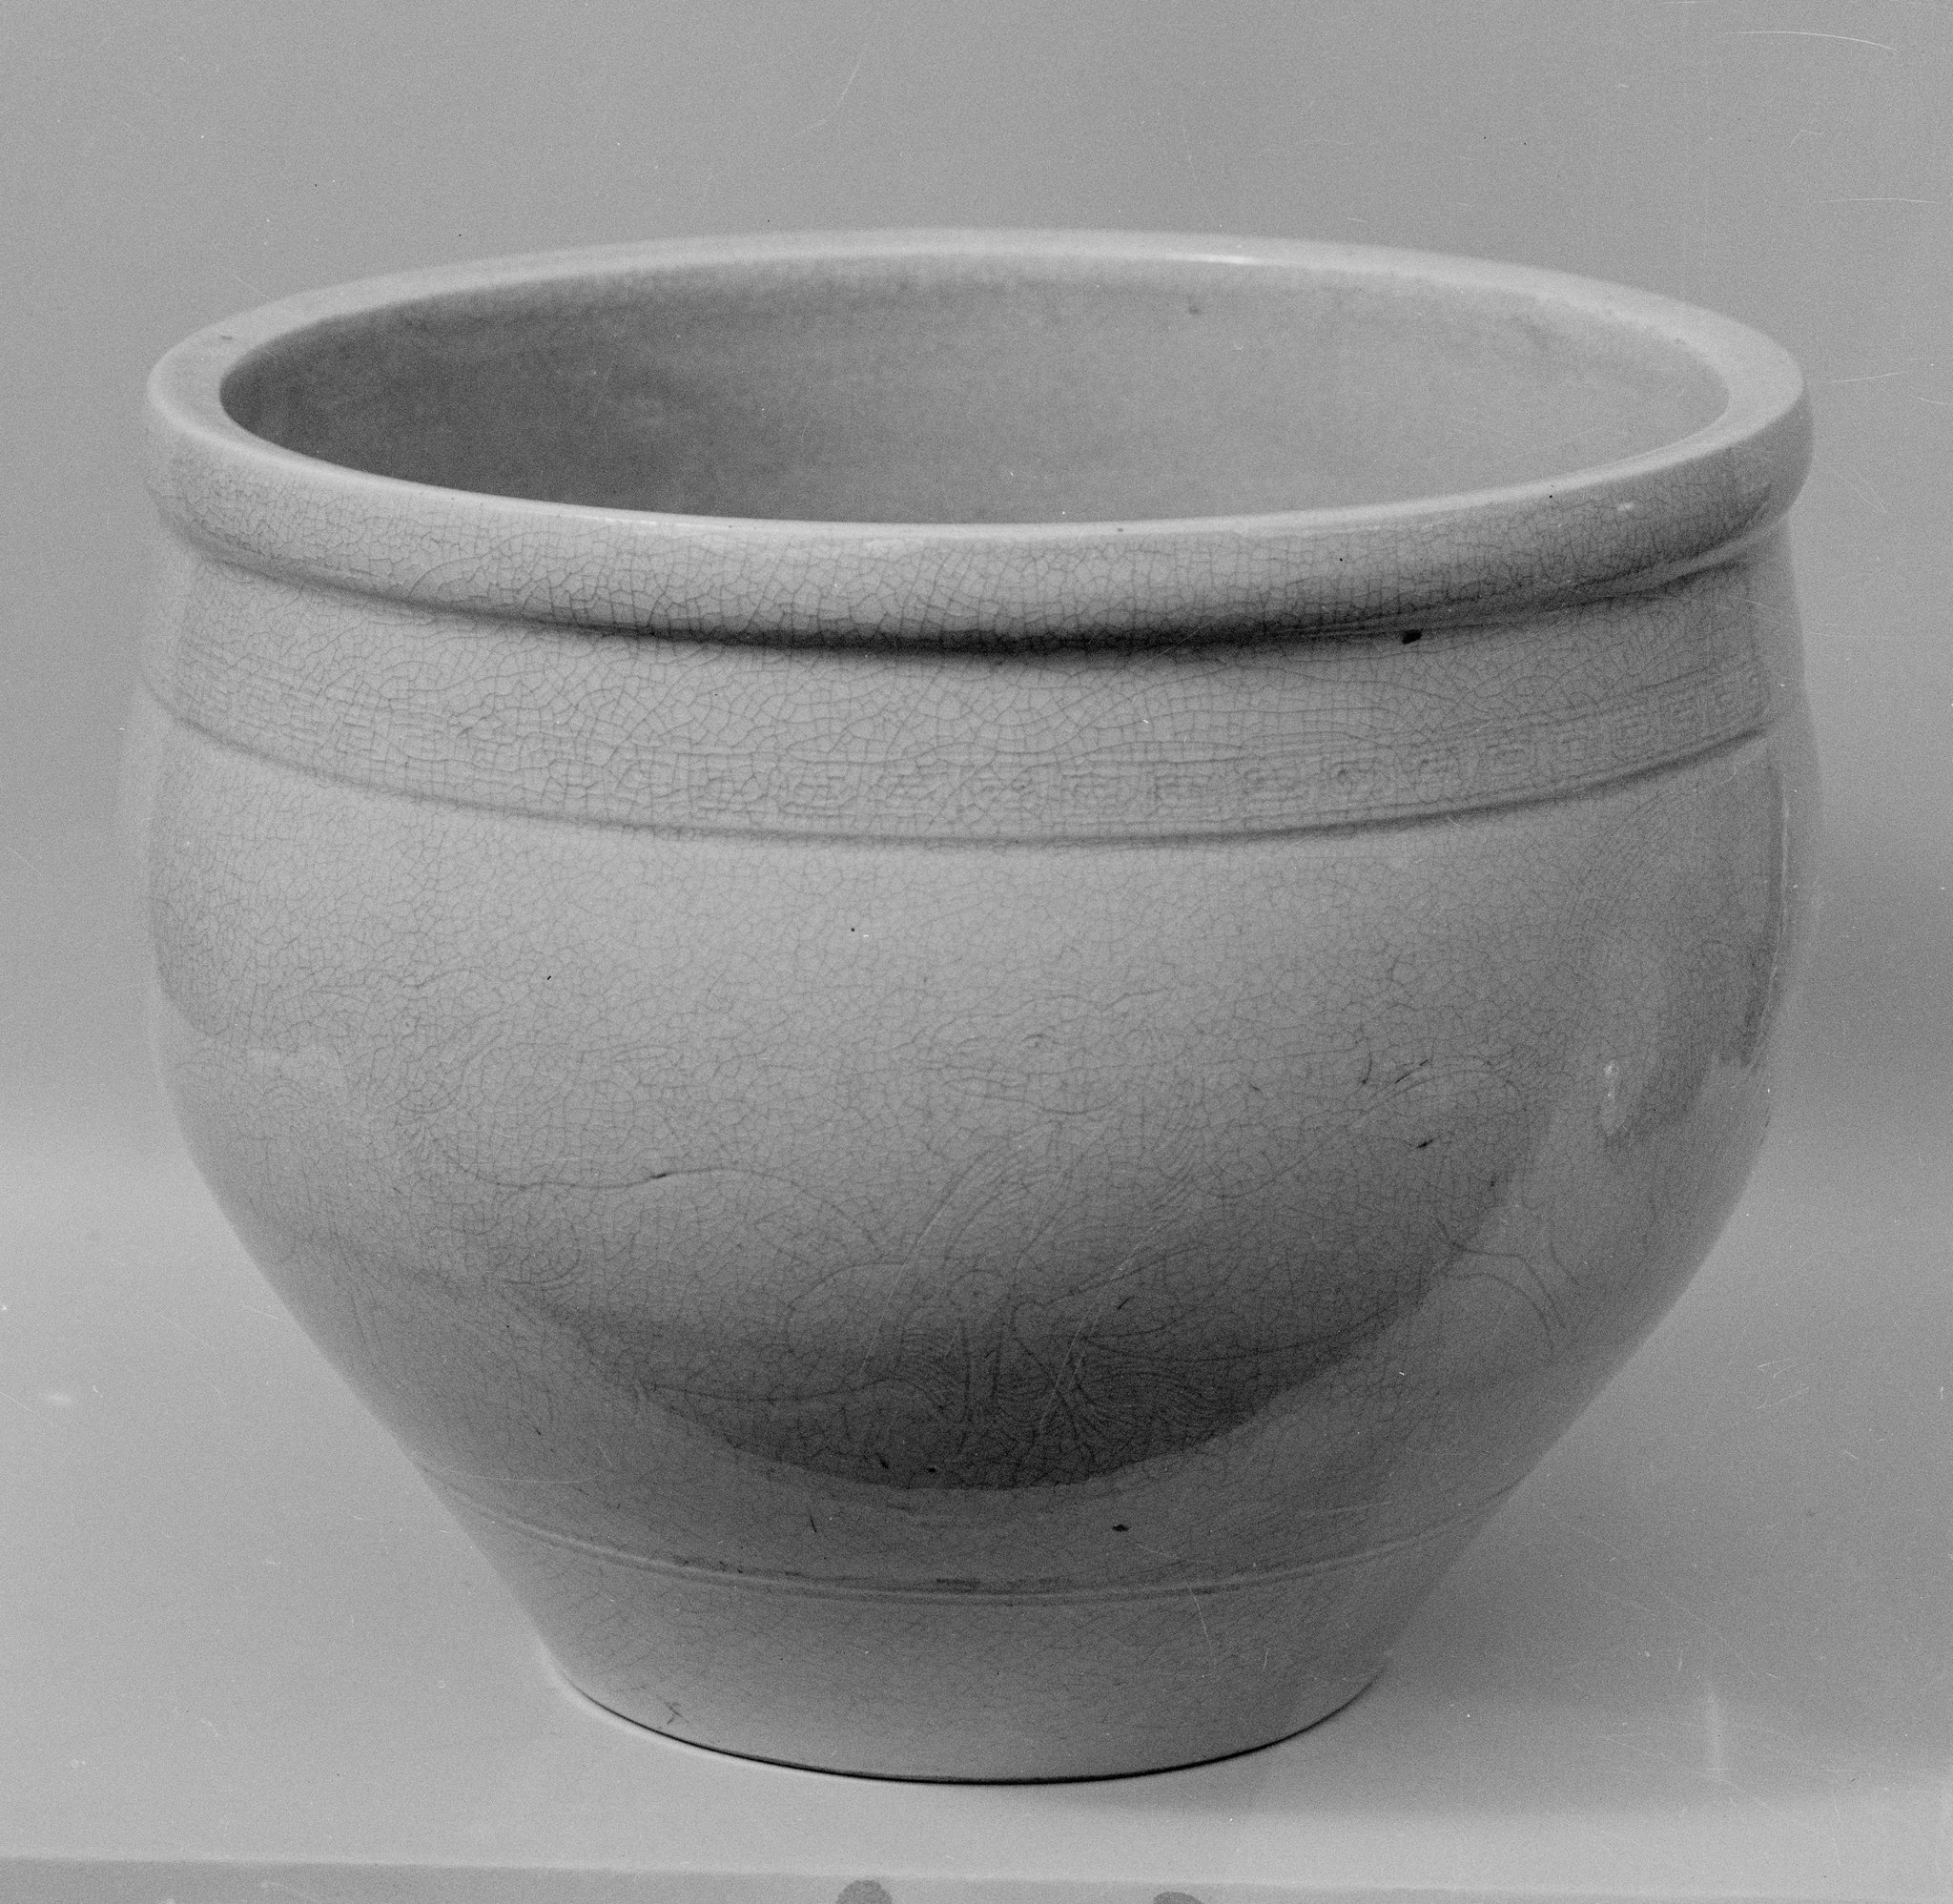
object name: jar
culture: chinese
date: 1368-1644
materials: porcelain